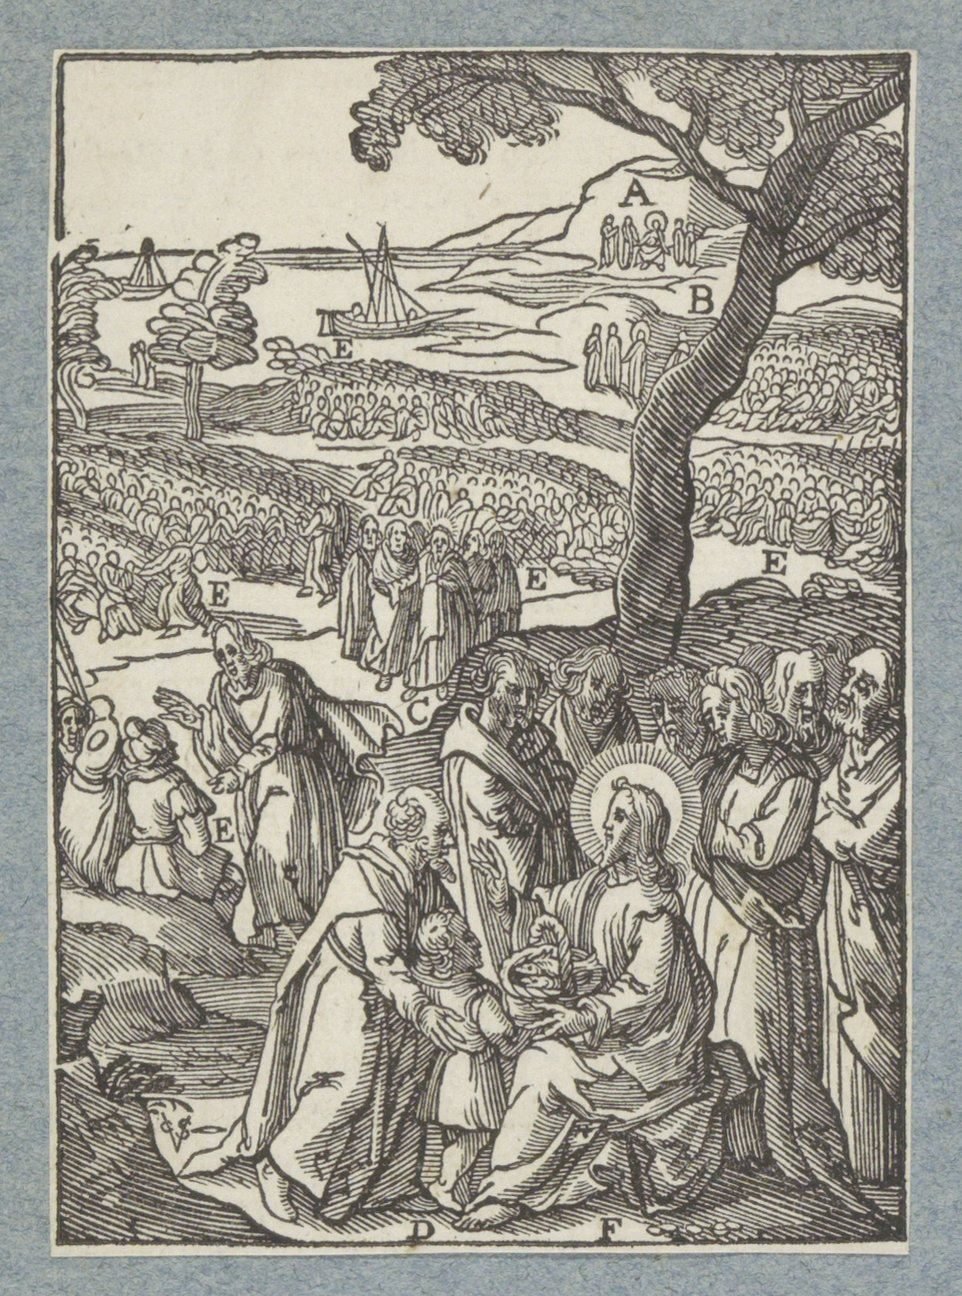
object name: print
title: Wonderbaarlijke spijziging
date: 1629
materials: paper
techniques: letterpress printing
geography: amsterdam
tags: multiplication of loaves and fishes for a multitude of four or five thousand people (matthew 14:13-21, 15:32-39; mark 6:32-44, 8:1-10; luke 9:10-17; john 6:1-14)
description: De prent is afkomstig uit een van de uitgaven van P.J. Paets uit Amsterdam. De prent wordt voor het eerst gebruikt in: Der Zielen Lust-hof. Leuven, I.Jacbosz voor P.J. Paets [= Amsterdam, P.J. Paets], 1629. De voorstelling is gekopieerd naar een prent van Antonie II Wierix voor: Nadal, Jerónimo. Evangelicae Historiae Imagines. Antwerpen, M. Nutius, 1593.